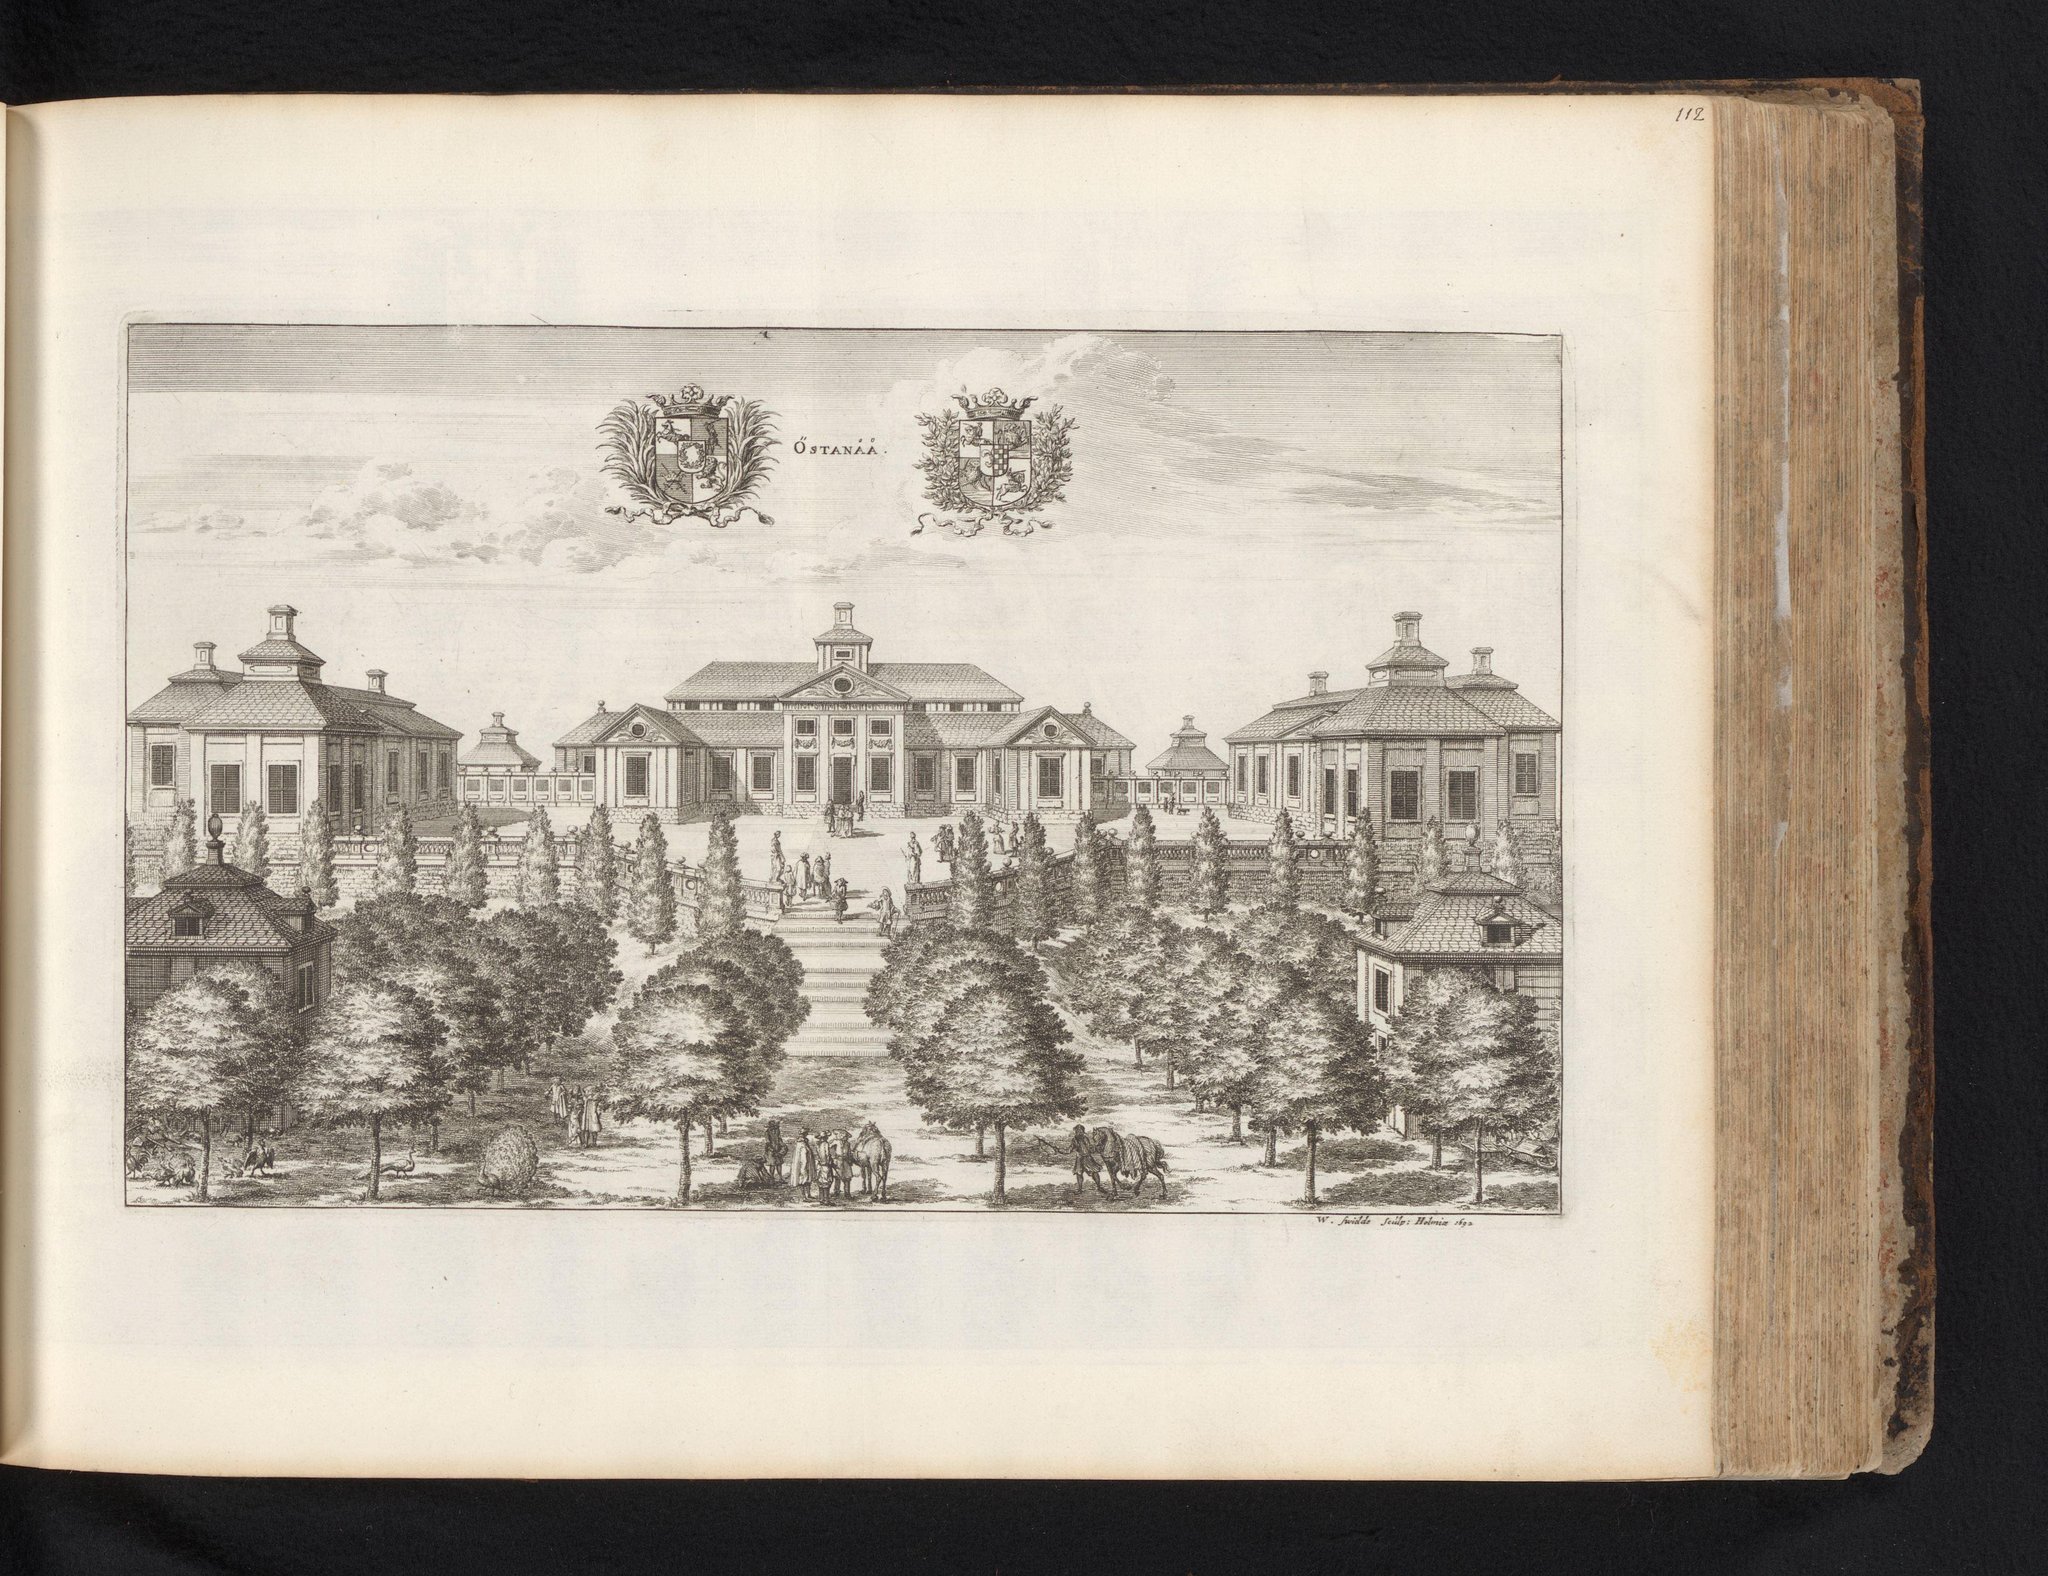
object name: album leaf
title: Suecia Antiqua et Hodierna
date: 1692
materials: paper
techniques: etching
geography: stockholm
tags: housing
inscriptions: date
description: Kungliga Biblioteket, 'Suecia': http://www.kb.se/samlingarna/Kartor-bilder/Suecia-antiqua/ (geraadpleegd november 2016).